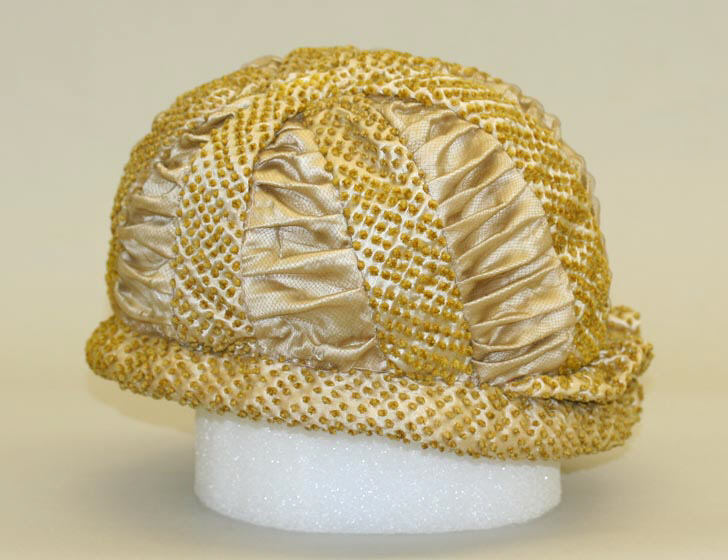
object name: turban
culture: french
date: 1804-1814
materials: silk